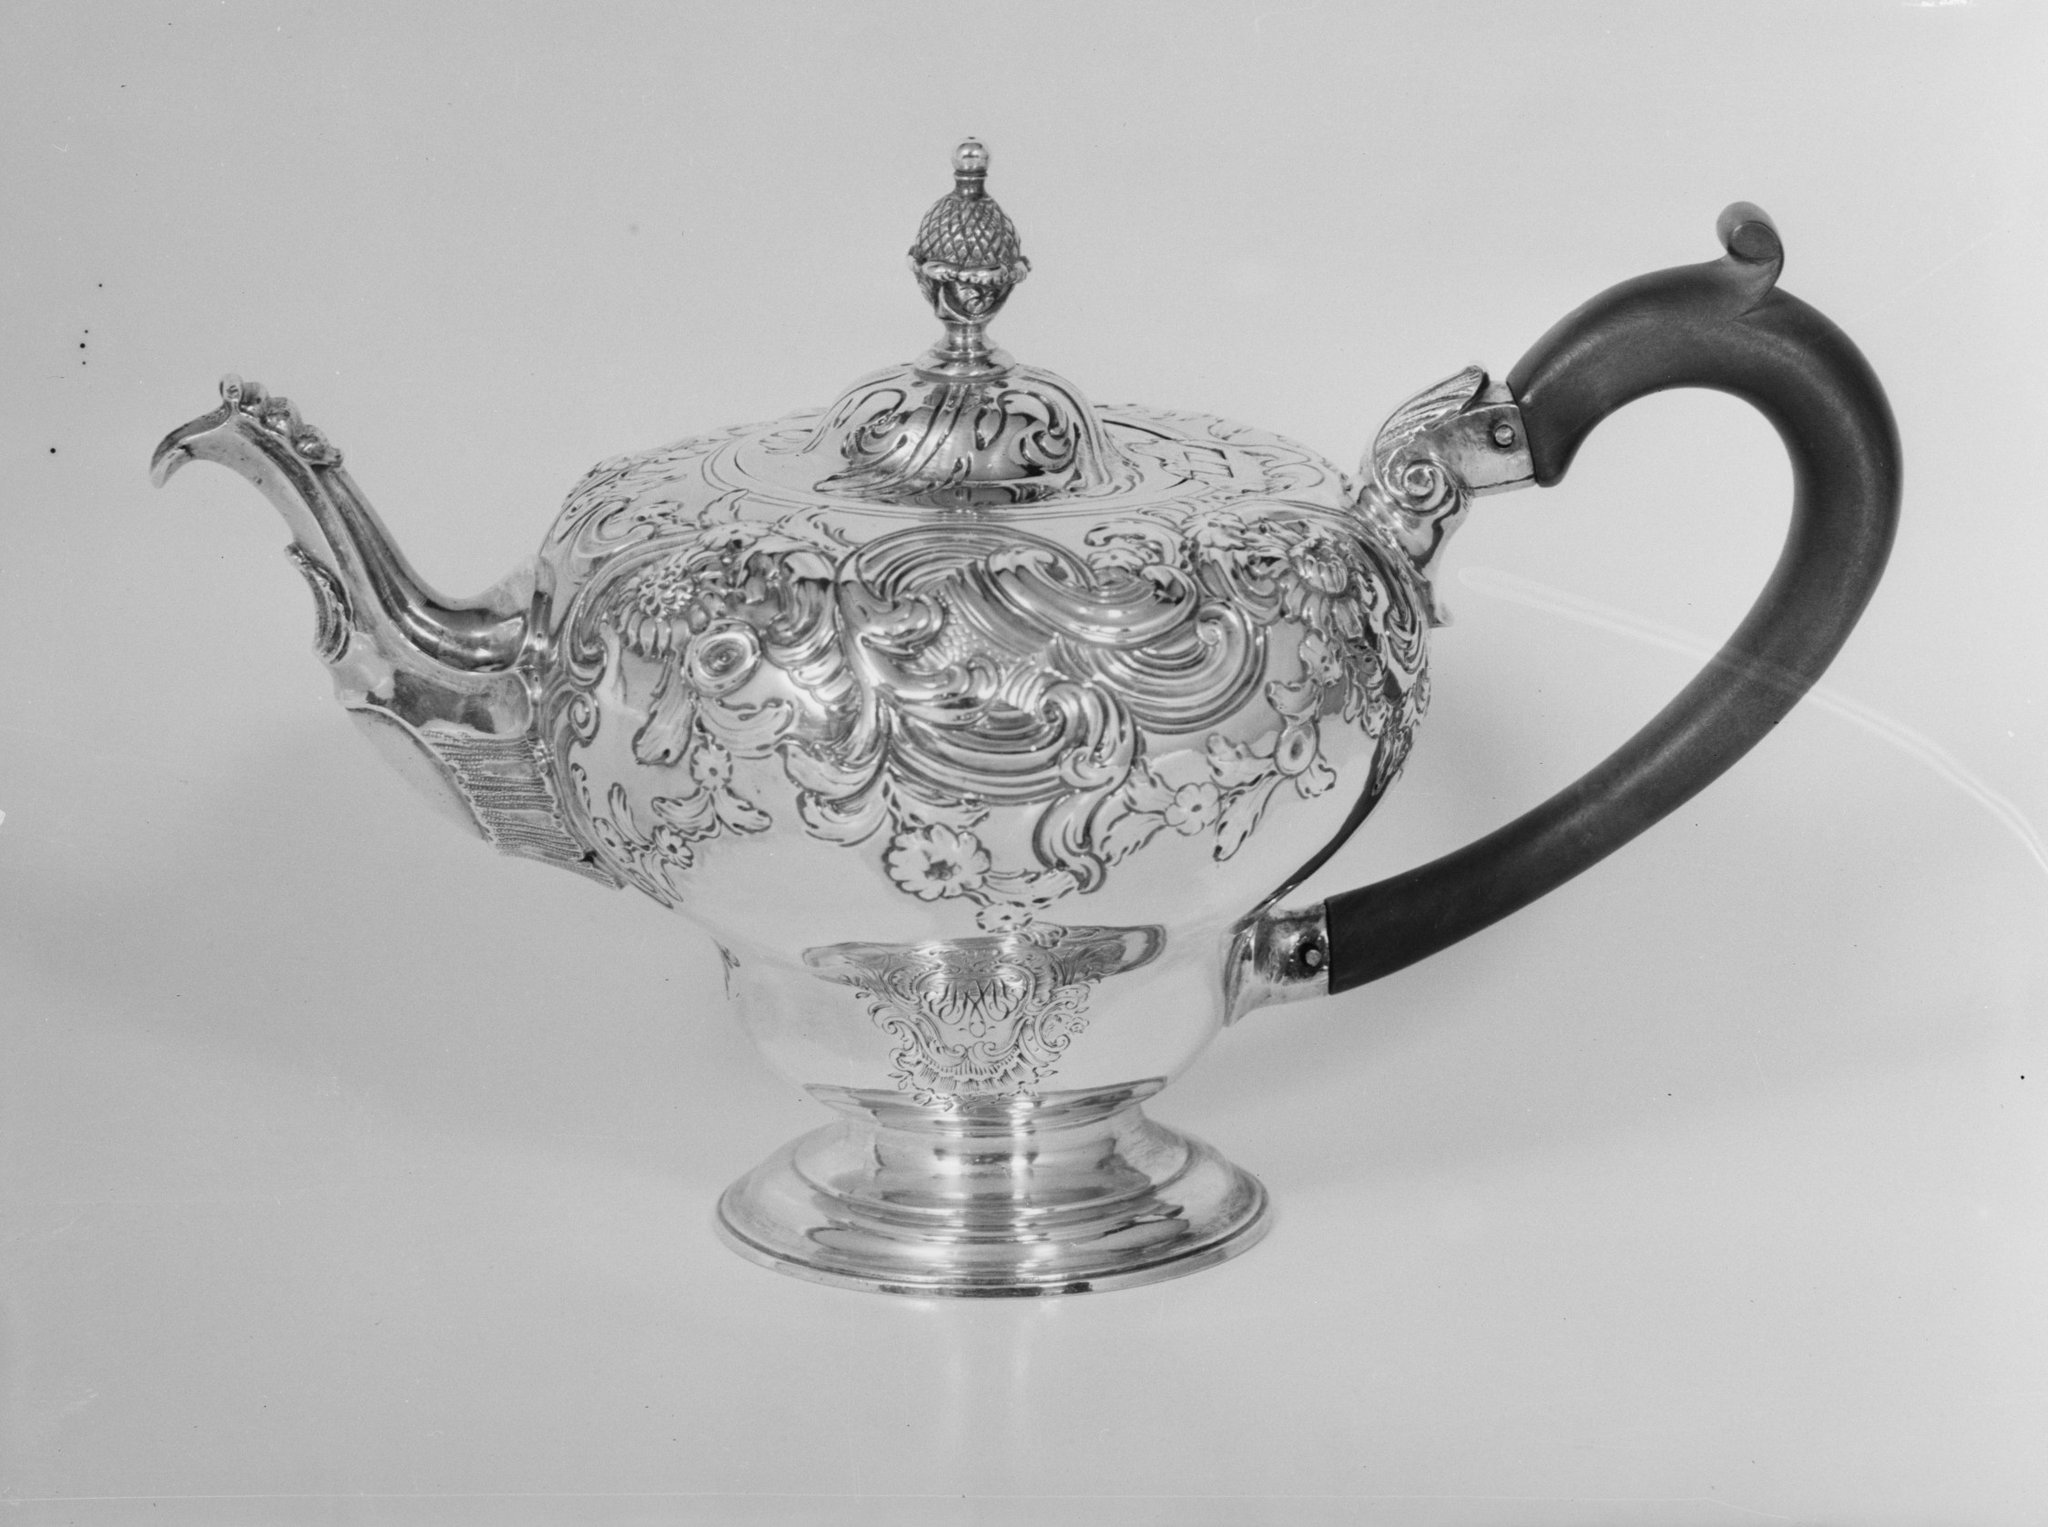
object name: teapot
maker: thomas whipham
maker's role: maker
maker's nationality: british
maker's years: 1737-1785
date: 1753-1754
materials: silver